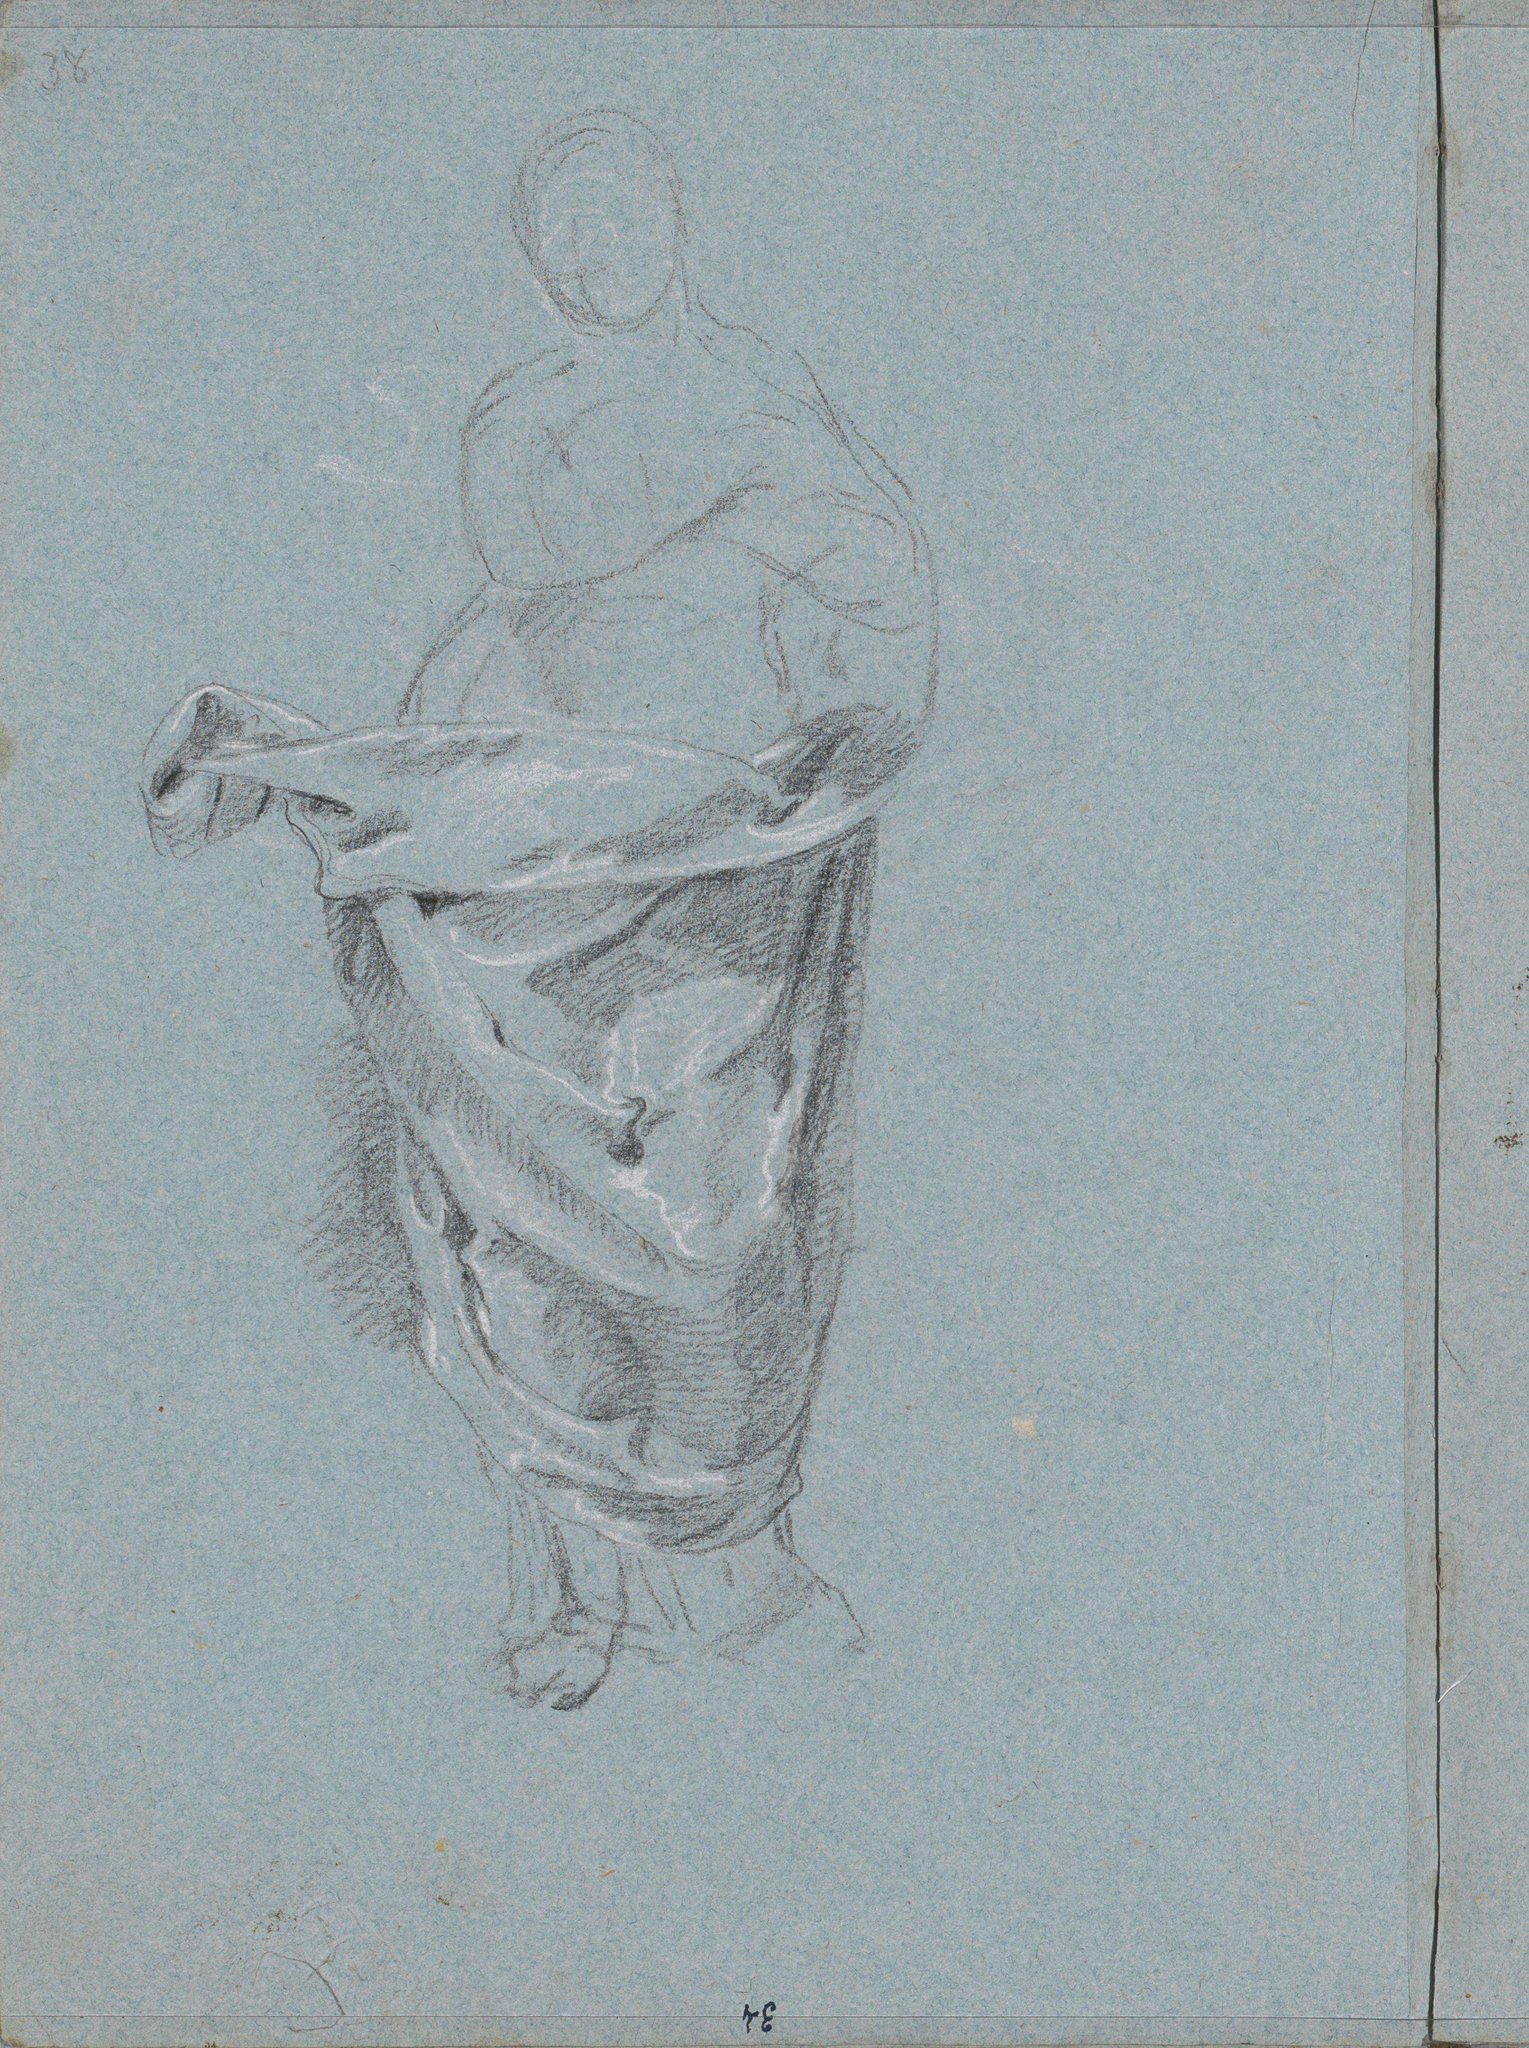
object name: sketchbook leaf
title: Halfnaakte staande vrouw met draperie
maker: lorenzo baldissera tiepolo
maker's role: draughtsman, print maker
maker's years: 1736-1776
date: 1751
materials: chalk, paper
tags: the (nude) human figure; 'corpo humano' (ripa) - aa - female human figure, drapery, draped garment, 'gewandgebung'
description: Bladzijde 38 uit een schetsboek met 158 bladzijden.